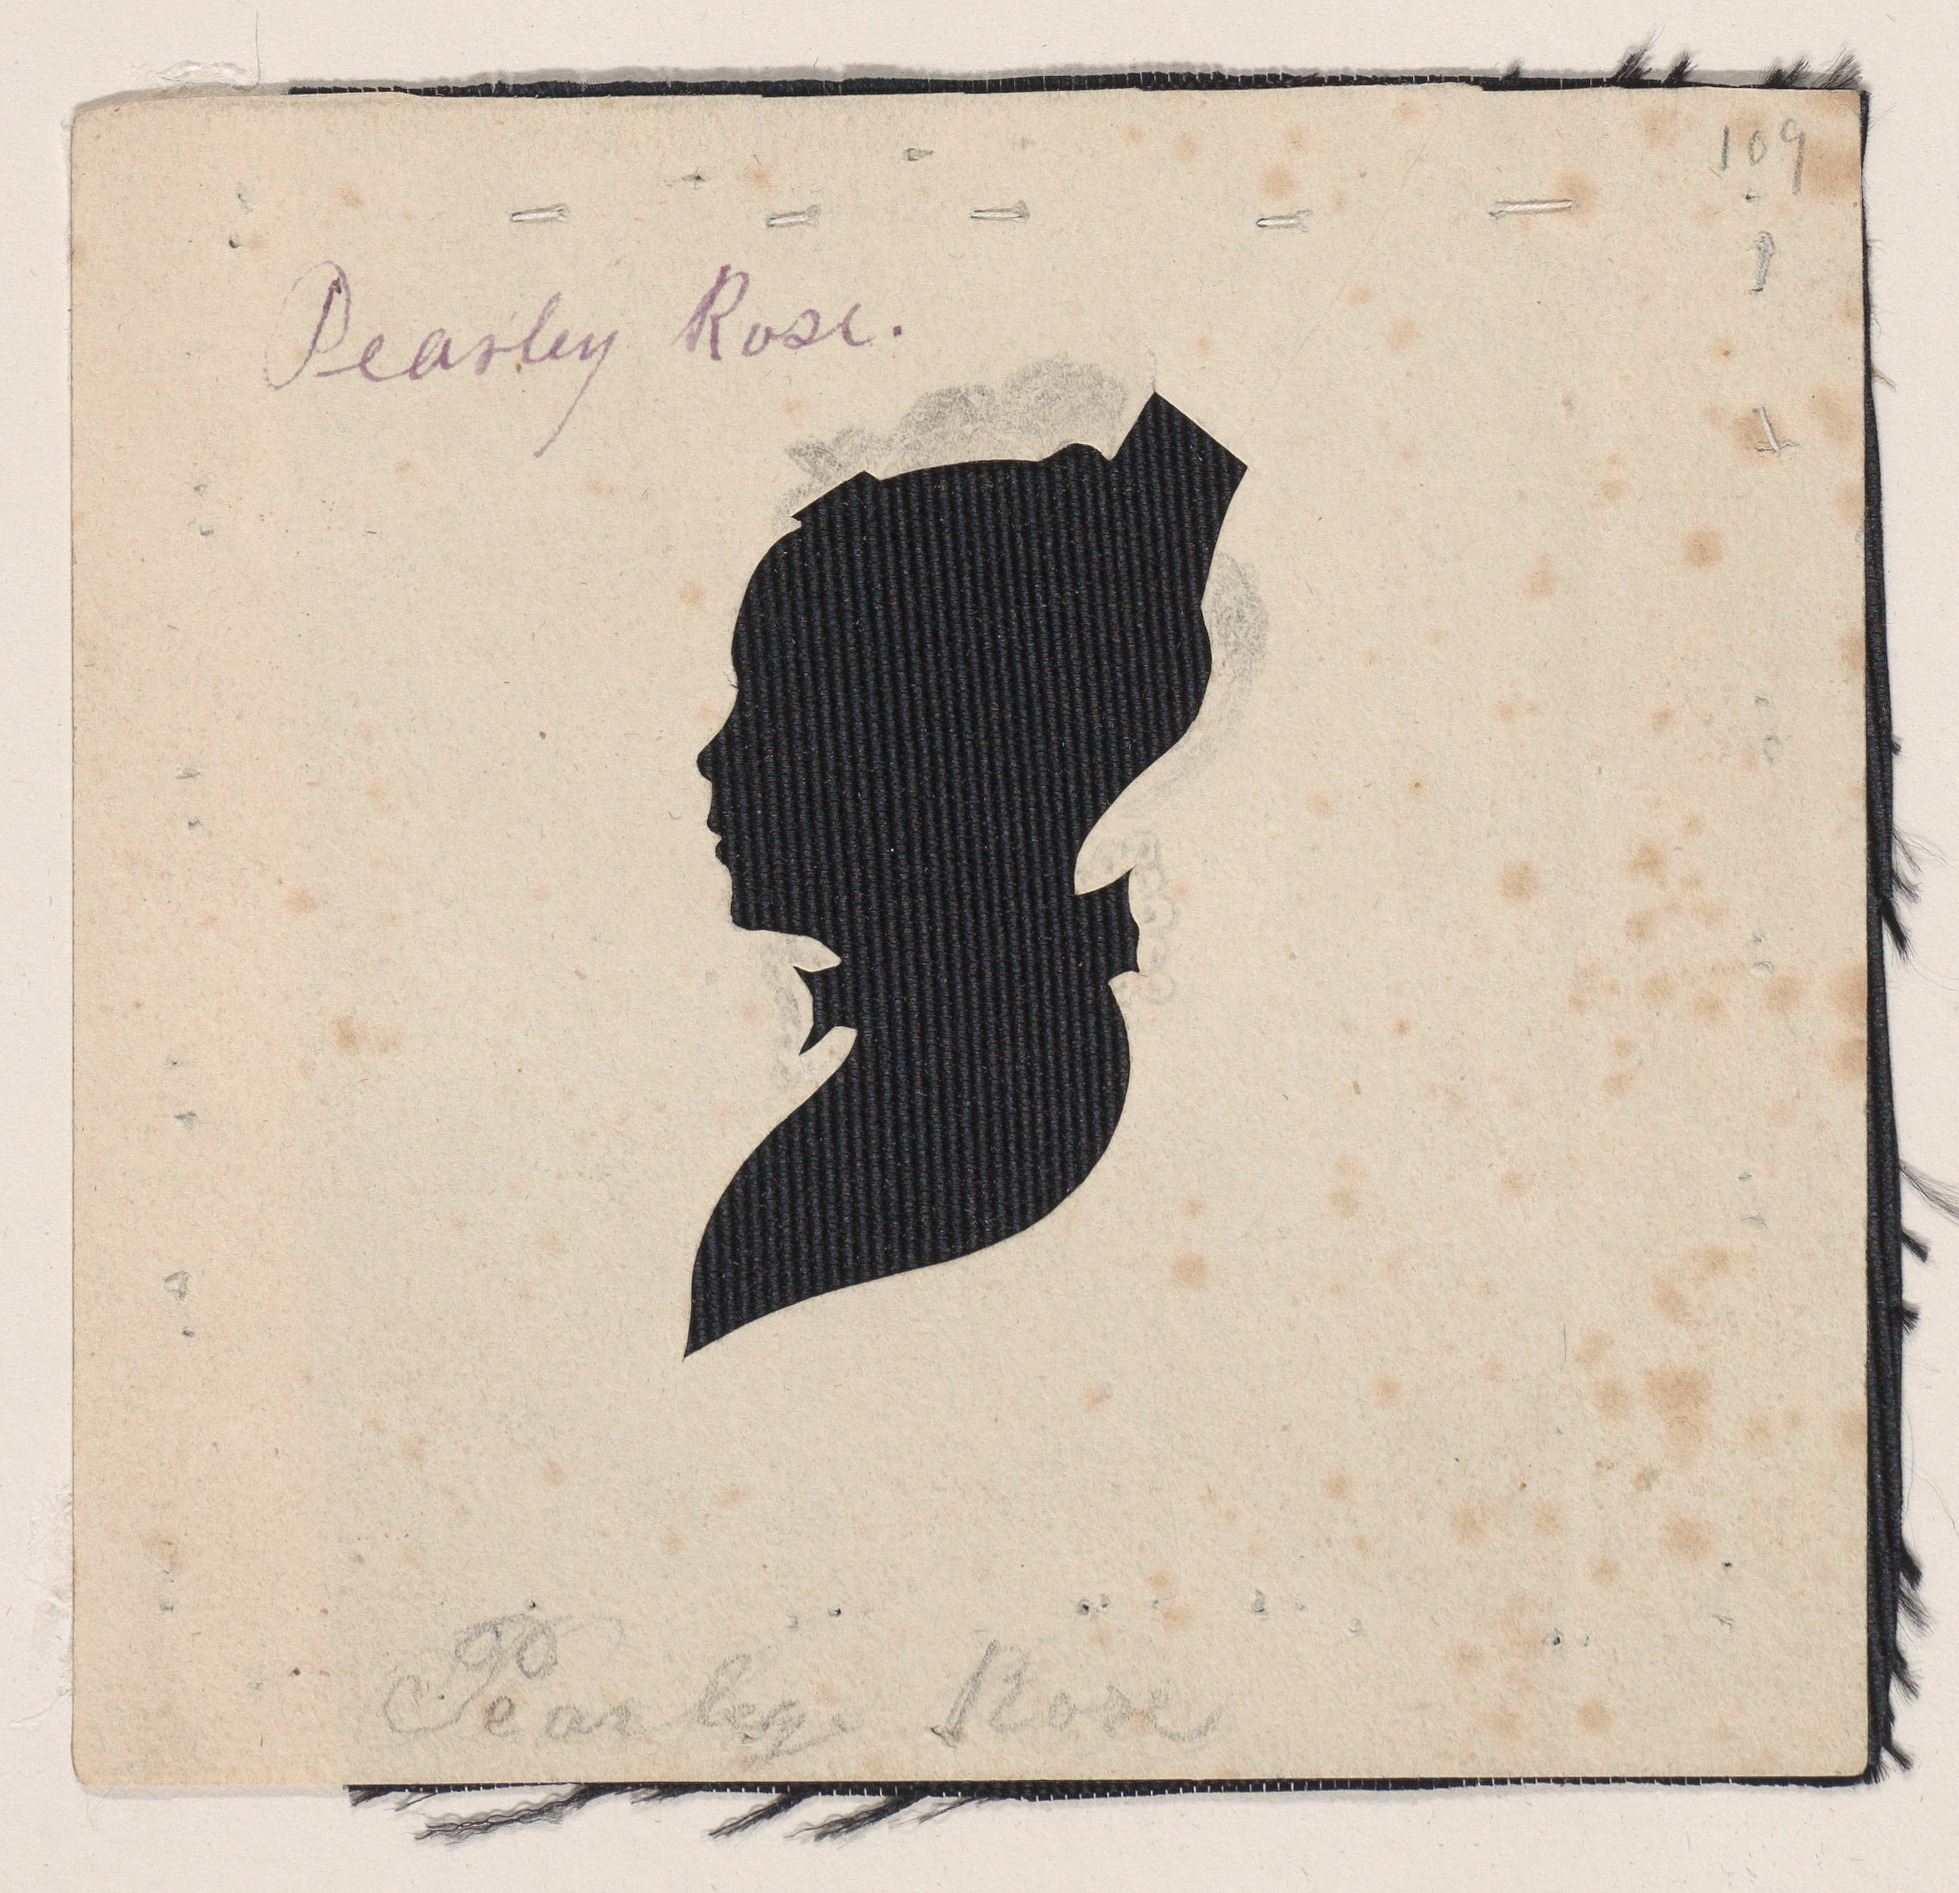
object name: cut paper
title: Silhouette of Pearley Rose, to left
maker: william chamberlain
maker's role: artist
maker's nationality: american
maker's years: 1790-1890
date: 1824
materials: paper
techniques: cutting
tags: women